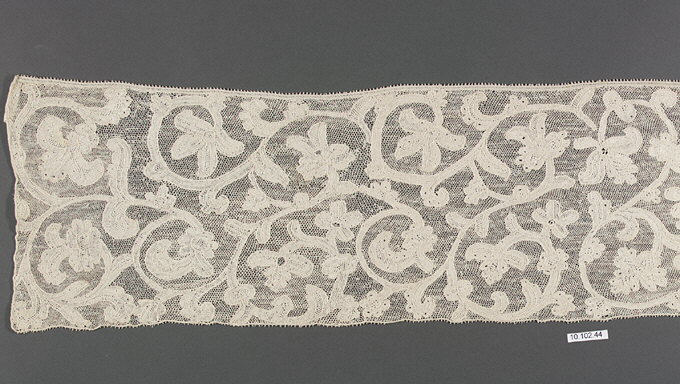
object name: flounce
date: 1701-1800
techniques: lace